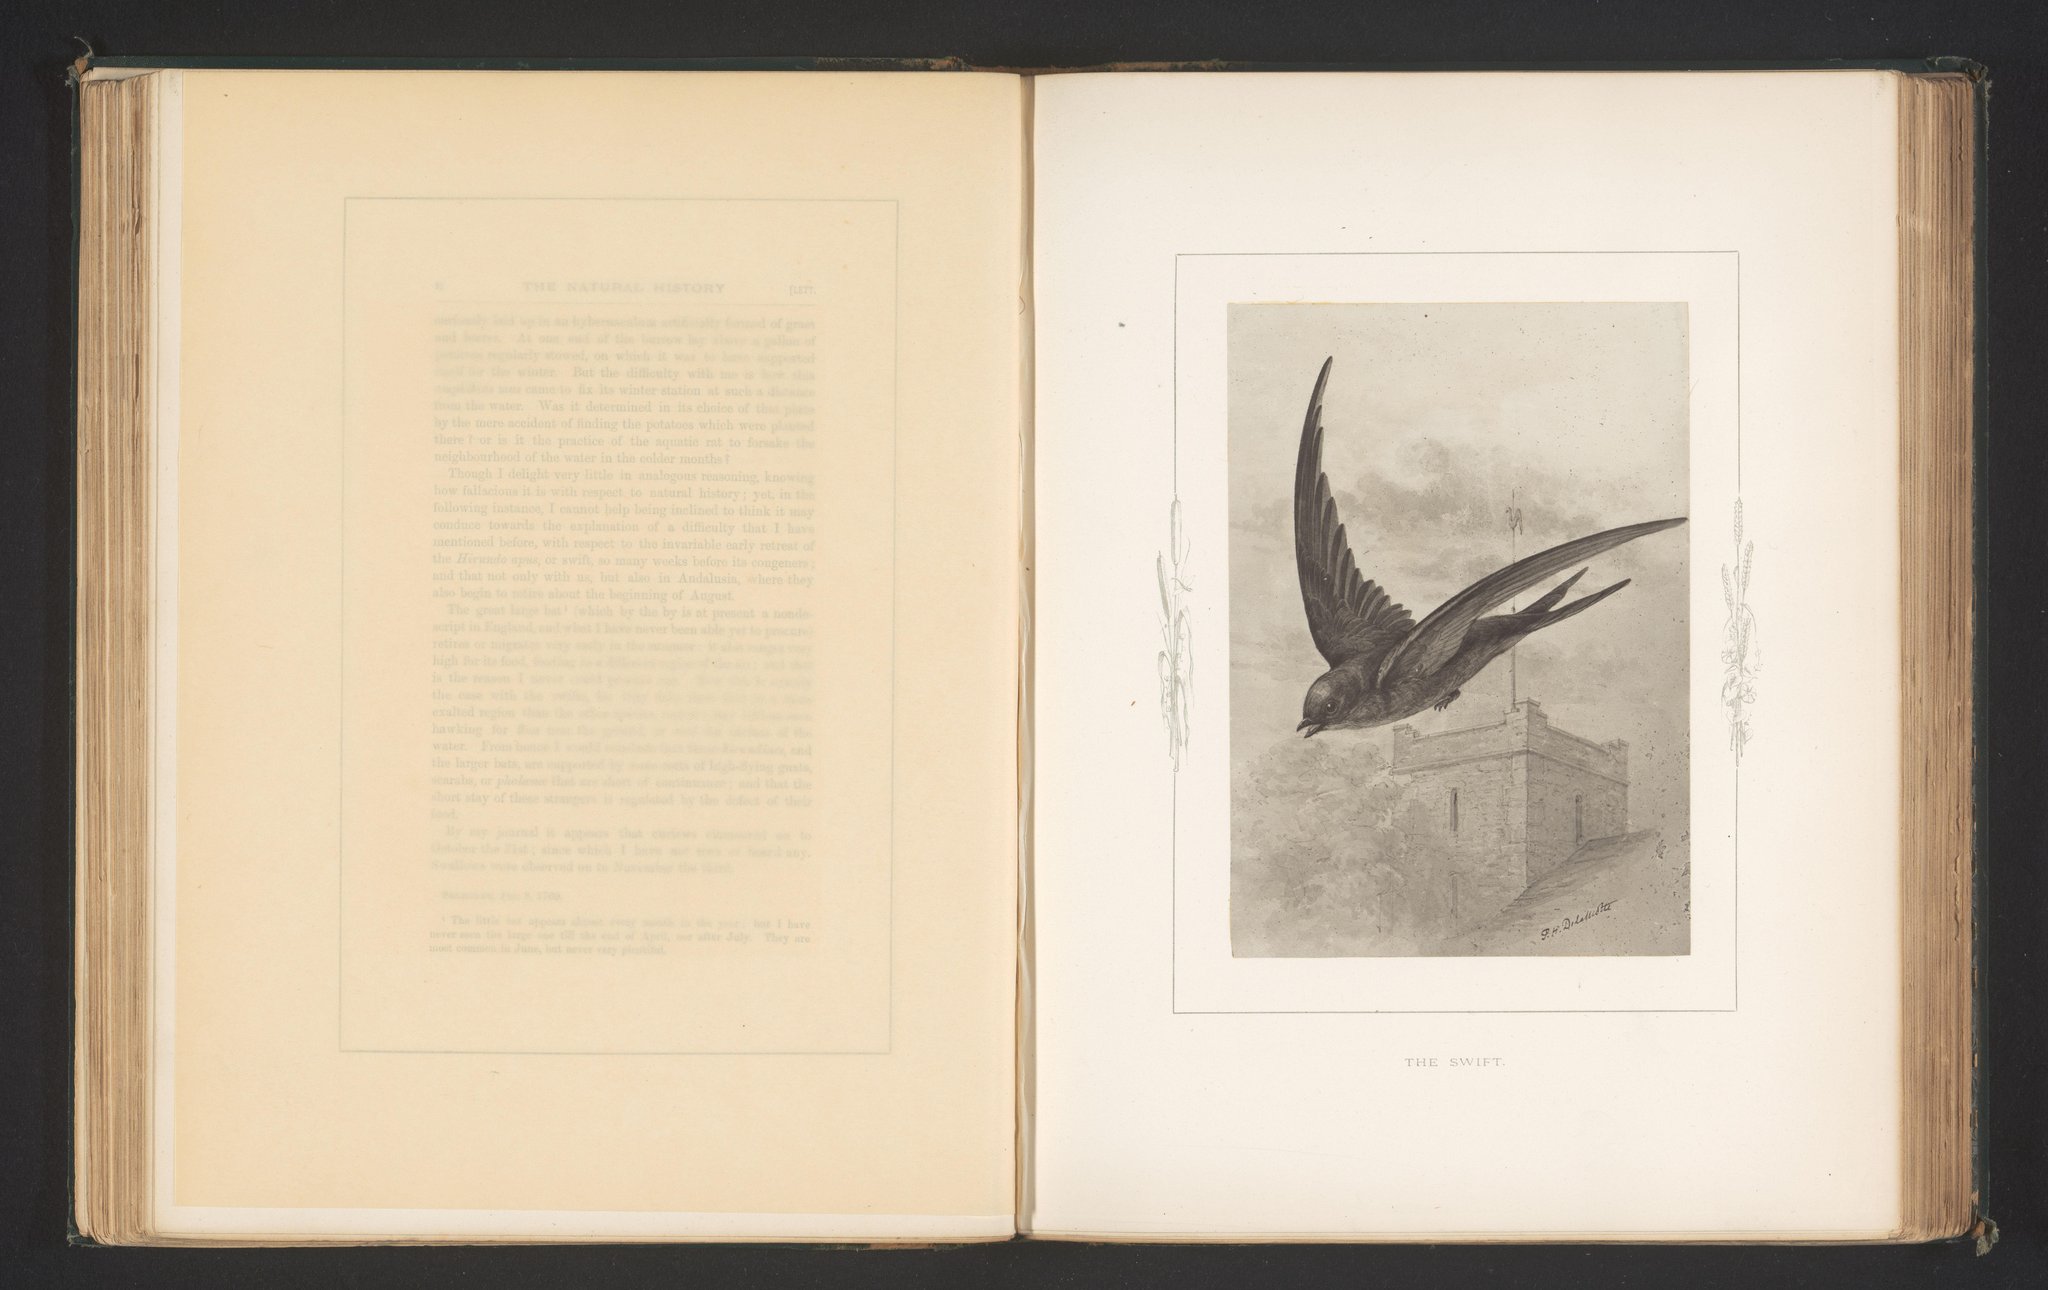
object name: reproduction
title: The swift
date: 1850-1876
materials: photographic support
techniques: carbon print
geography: selborne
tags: birds